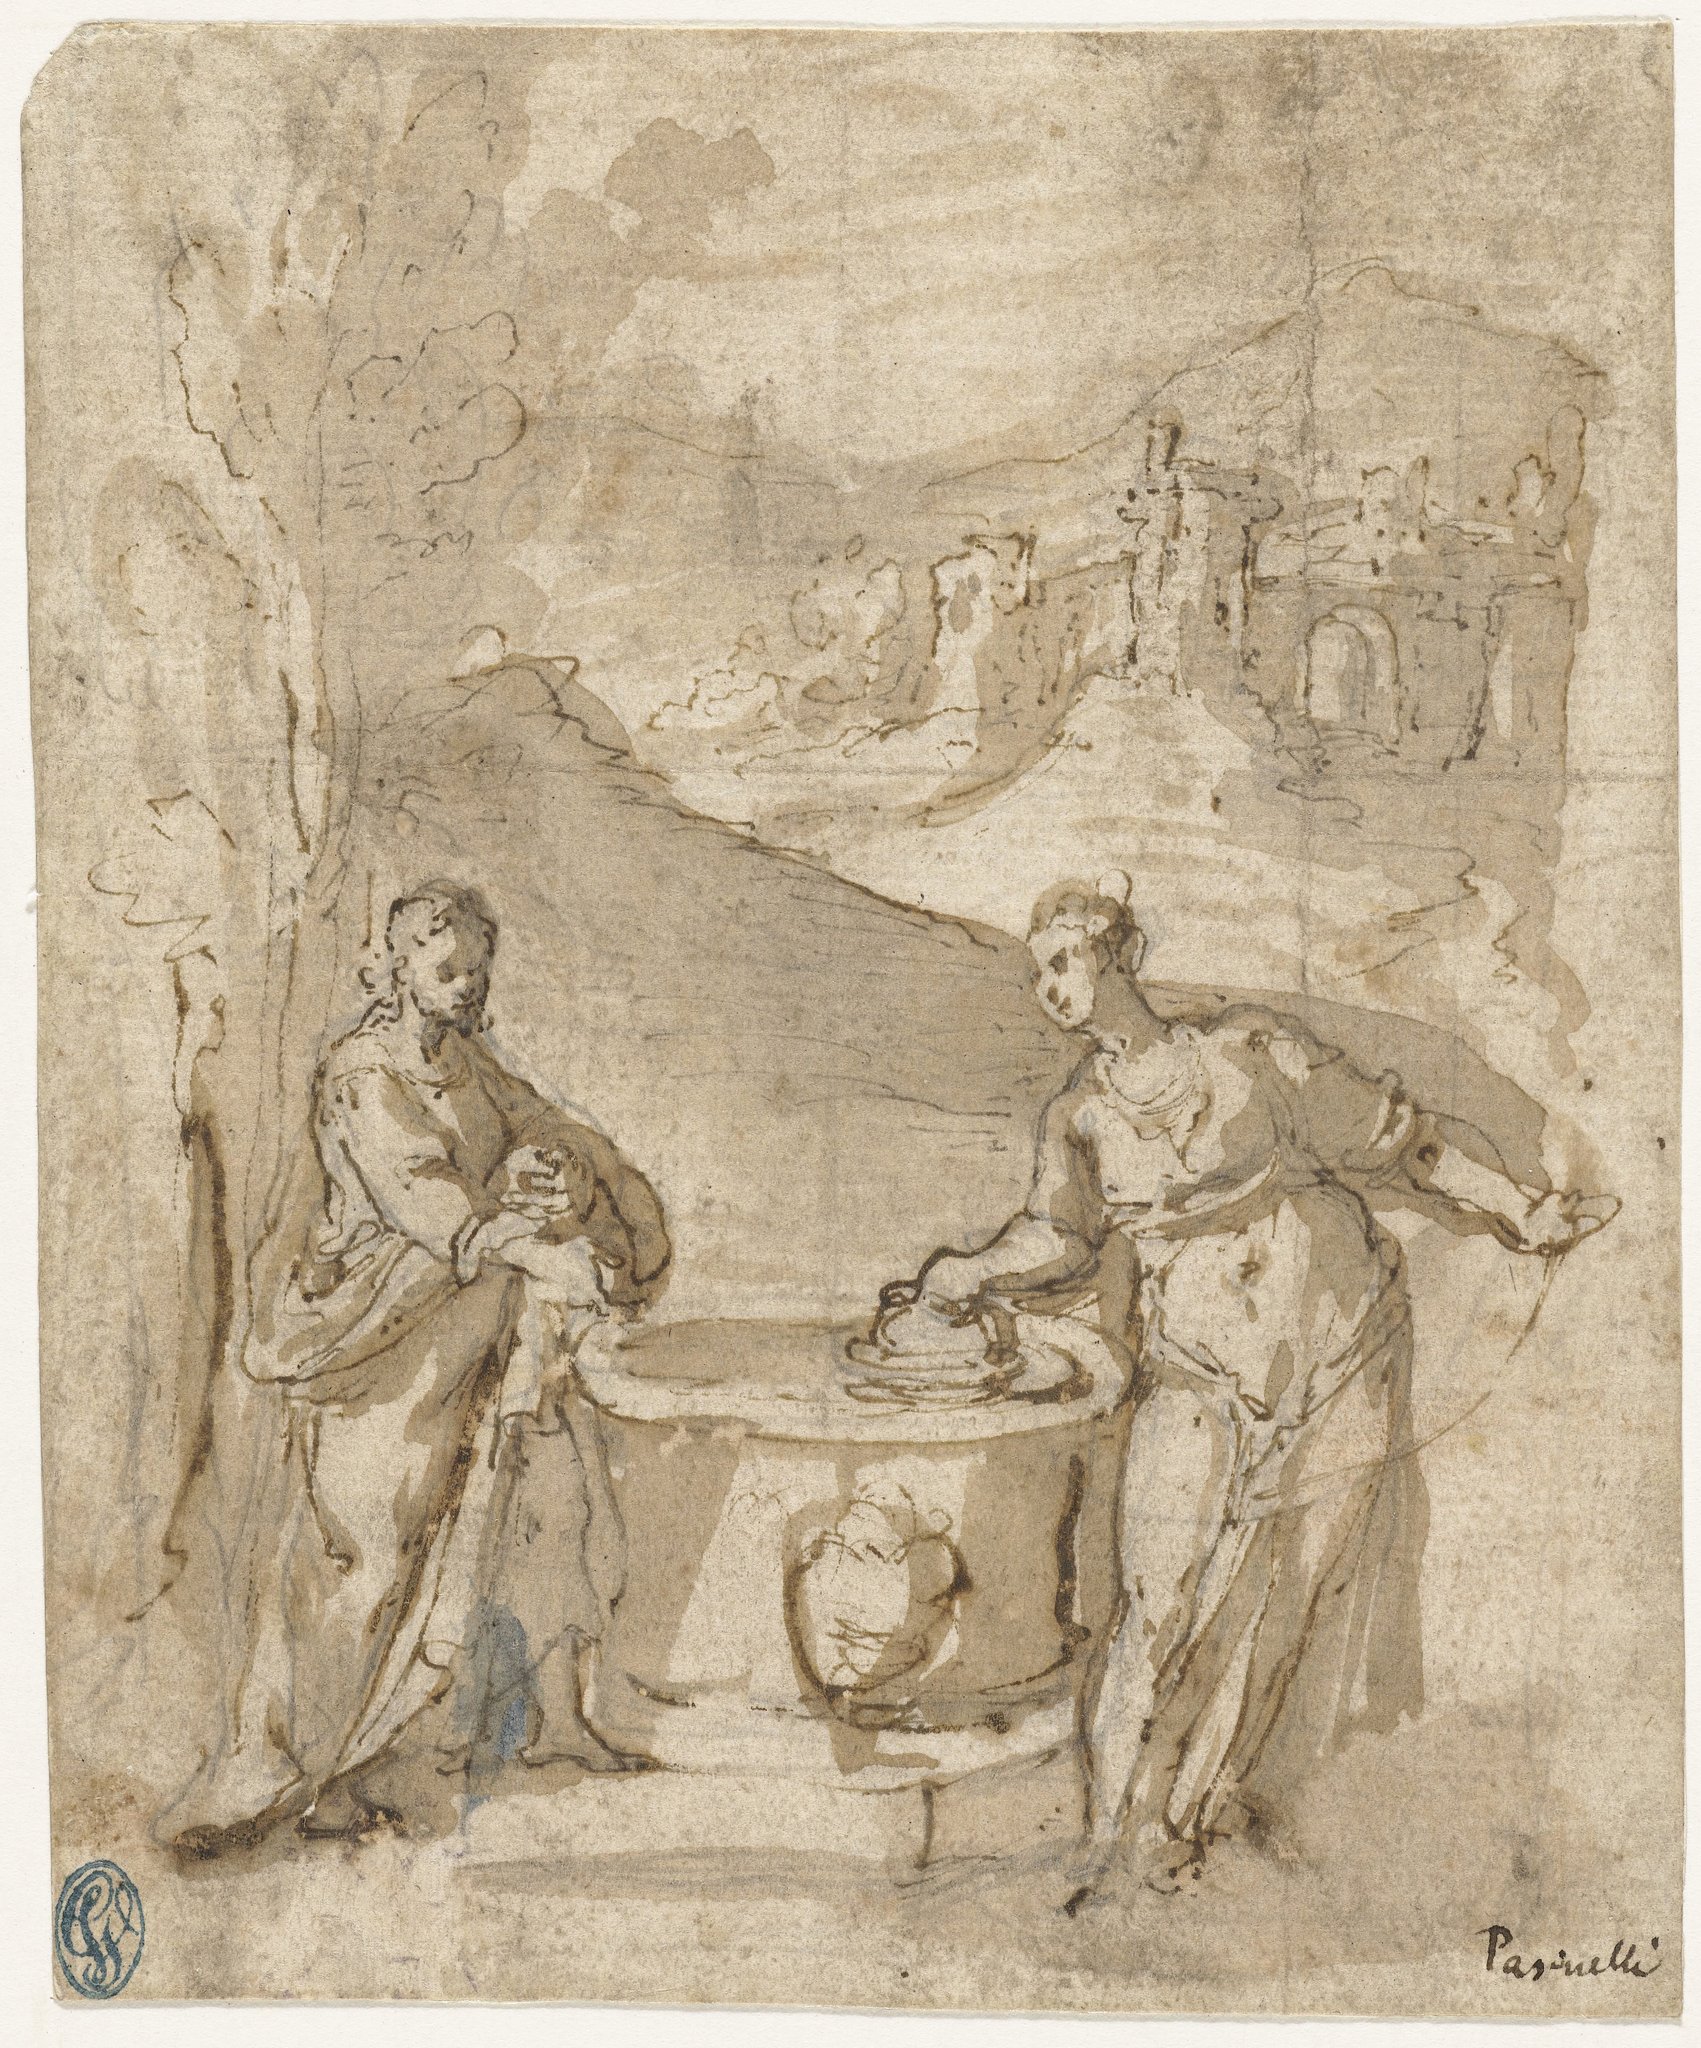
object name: drawing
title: Christus en de Samaritaanse vrouw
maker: lorenzo pasinelli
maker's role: draughtsman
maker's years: 1629-1700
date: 1639-1700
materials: chalk, graphite, ink, paper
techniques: brush, pen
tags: christ and the woman of samaria: sitting at jacob's well he asks her for a drink from her jug